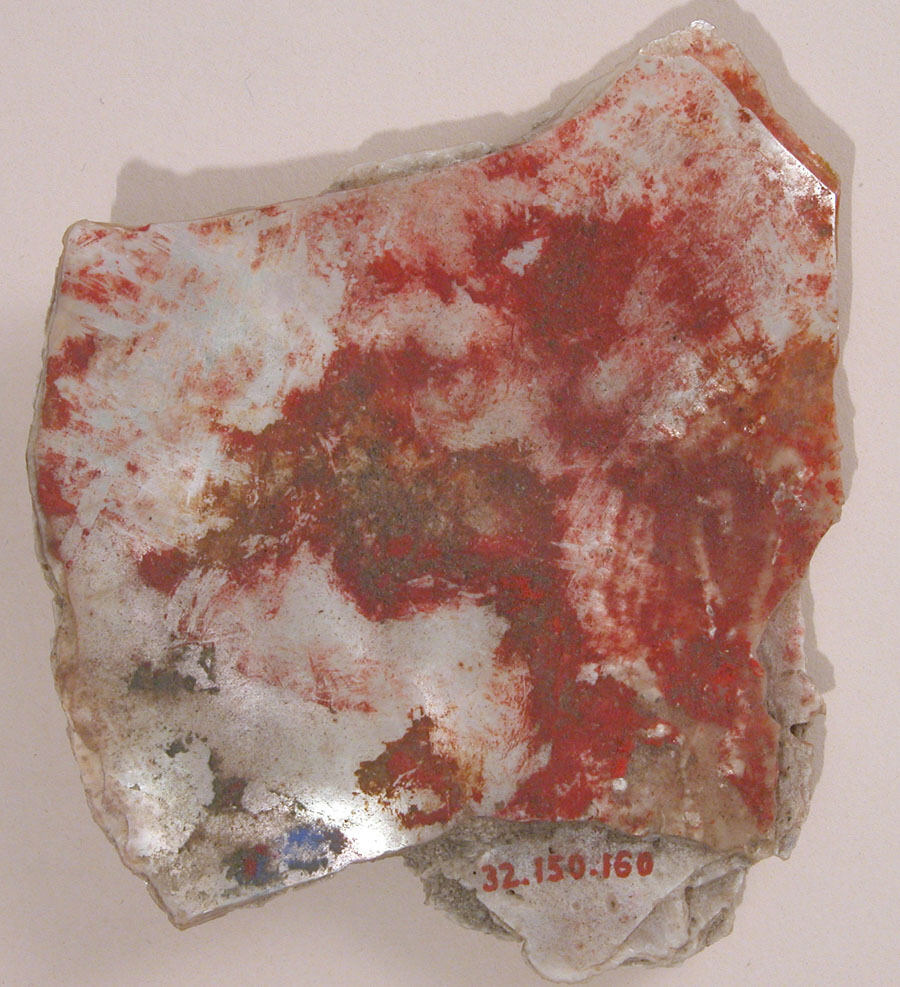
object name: fragment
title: Shell Fragment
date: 601-1000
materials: pigment, shell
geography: iraq